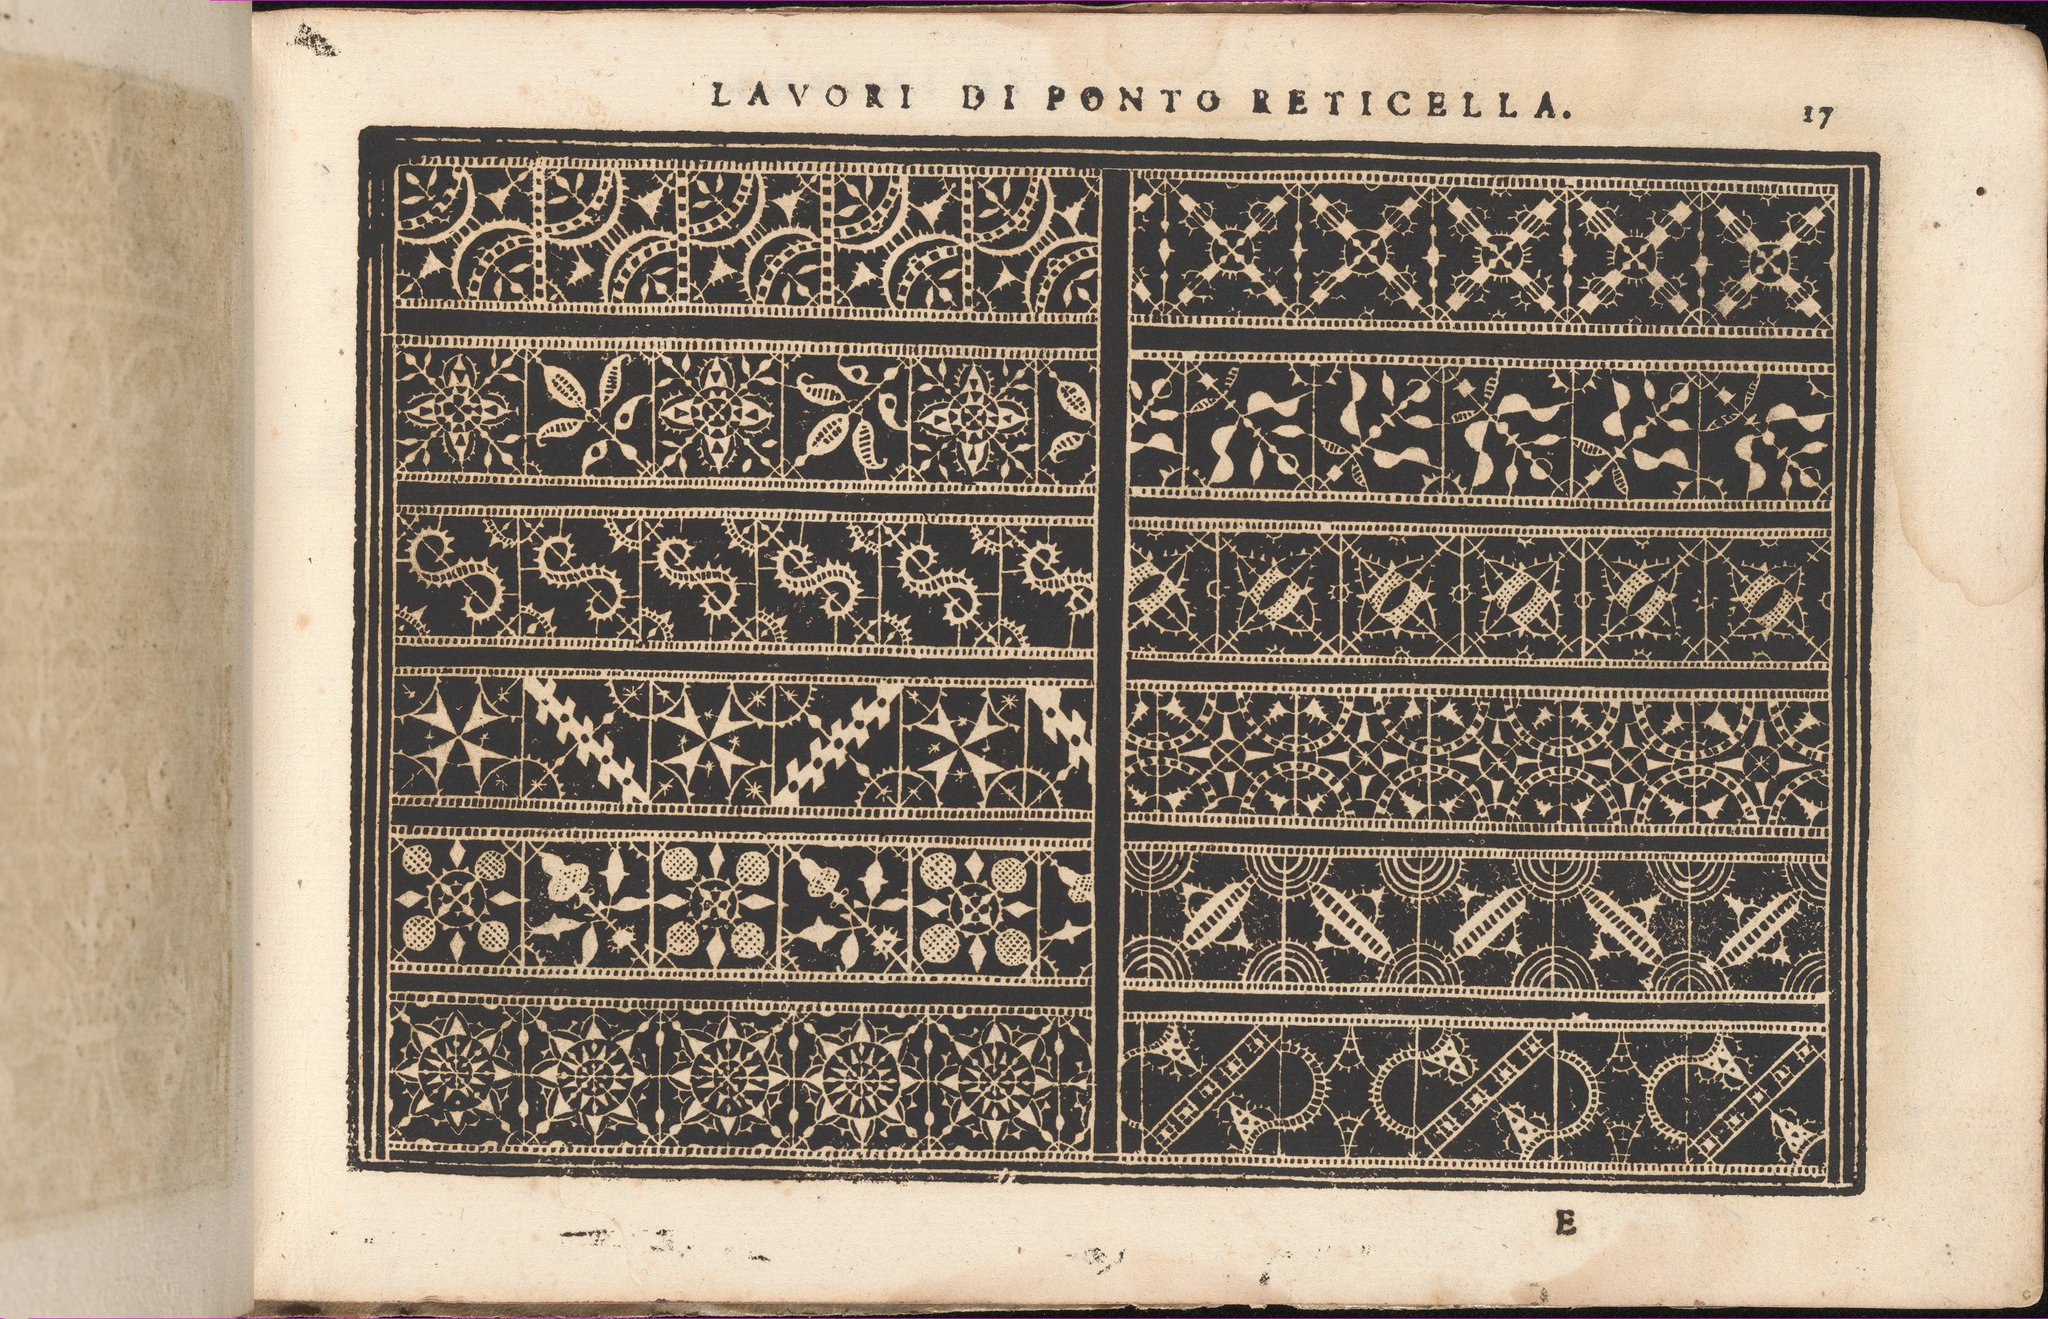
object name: book print ornament architecture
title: Teatro delle Nobili et Virtuose Donne..., page 15 (recto)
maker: isabella catanea parasole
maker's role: author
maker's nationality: italian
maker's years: 1565-1625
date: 1616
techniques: engraving, woodcut